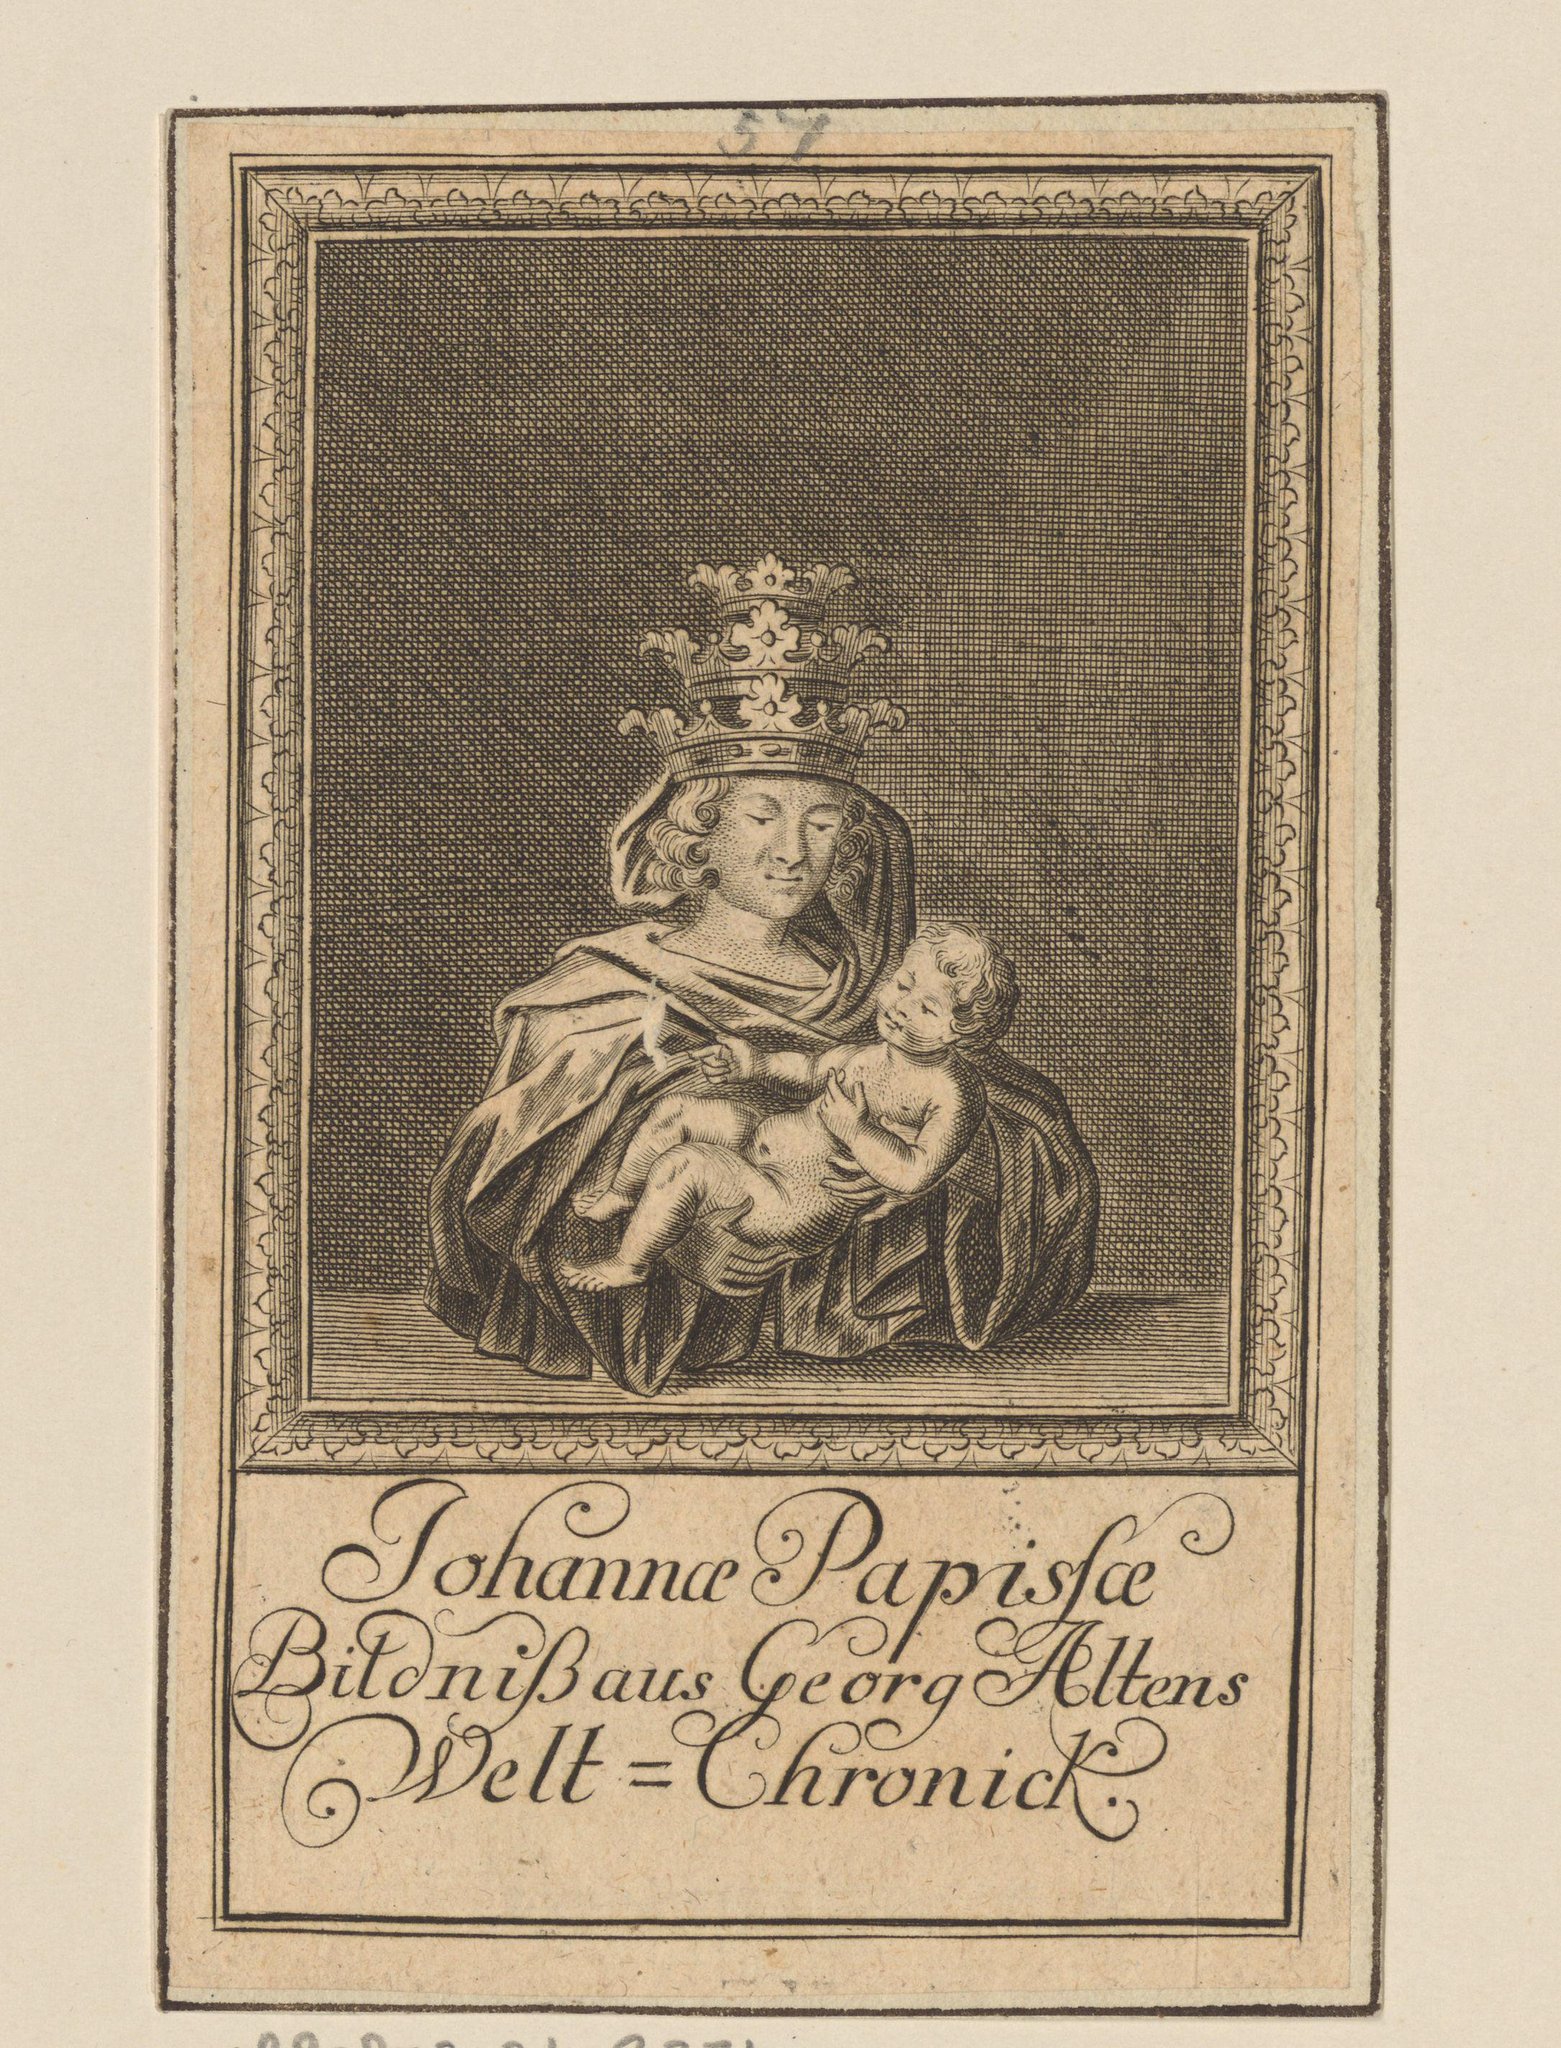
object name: print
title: Pausin Johanna met Christus in haar armen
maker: Anonymous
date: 1650-1749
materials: paper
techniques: engraving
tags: adult woman, christ as child or youth (in general) ~ christian religion, pope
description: Deze prent is gemaakt naar een houtsnede uit de 'Kroniek van Neurenberg' door Hartmann Schedel in 1493.